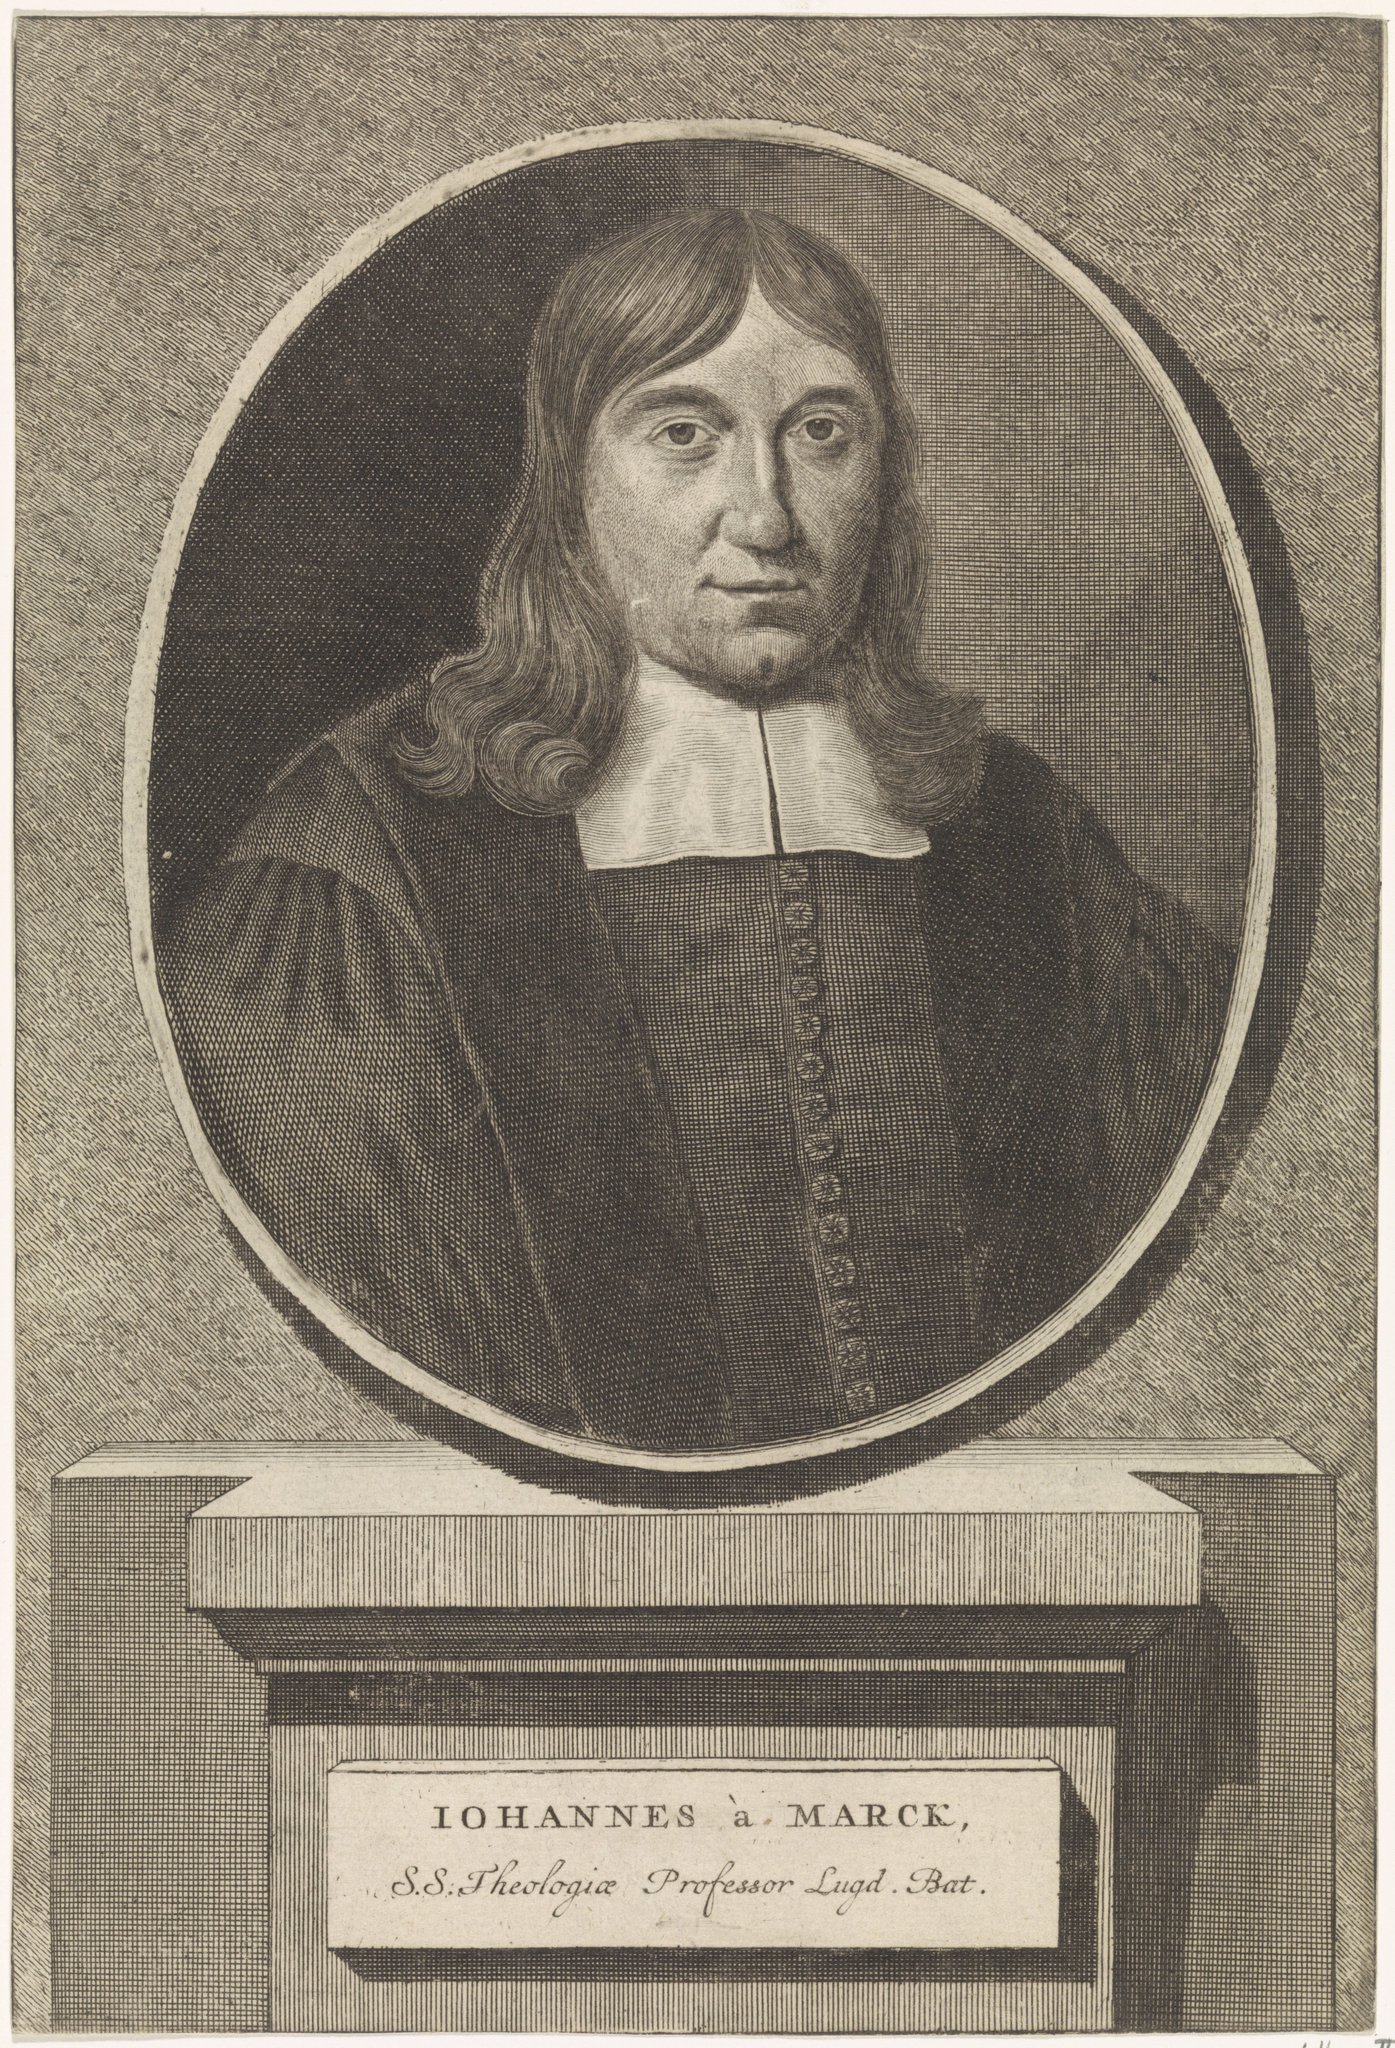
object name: book illustration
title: Portret van Johannes à Marck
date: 1720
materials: paper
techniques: engraving, etching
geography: leiden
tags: leiden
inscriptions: collector's mark: Lugt 2228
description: Prent uit: XIX. Imagines Quorundam Clarissimorum Theologorum & Philologorum. Leiden: Pieter van der Aa (I), [c. 1720].